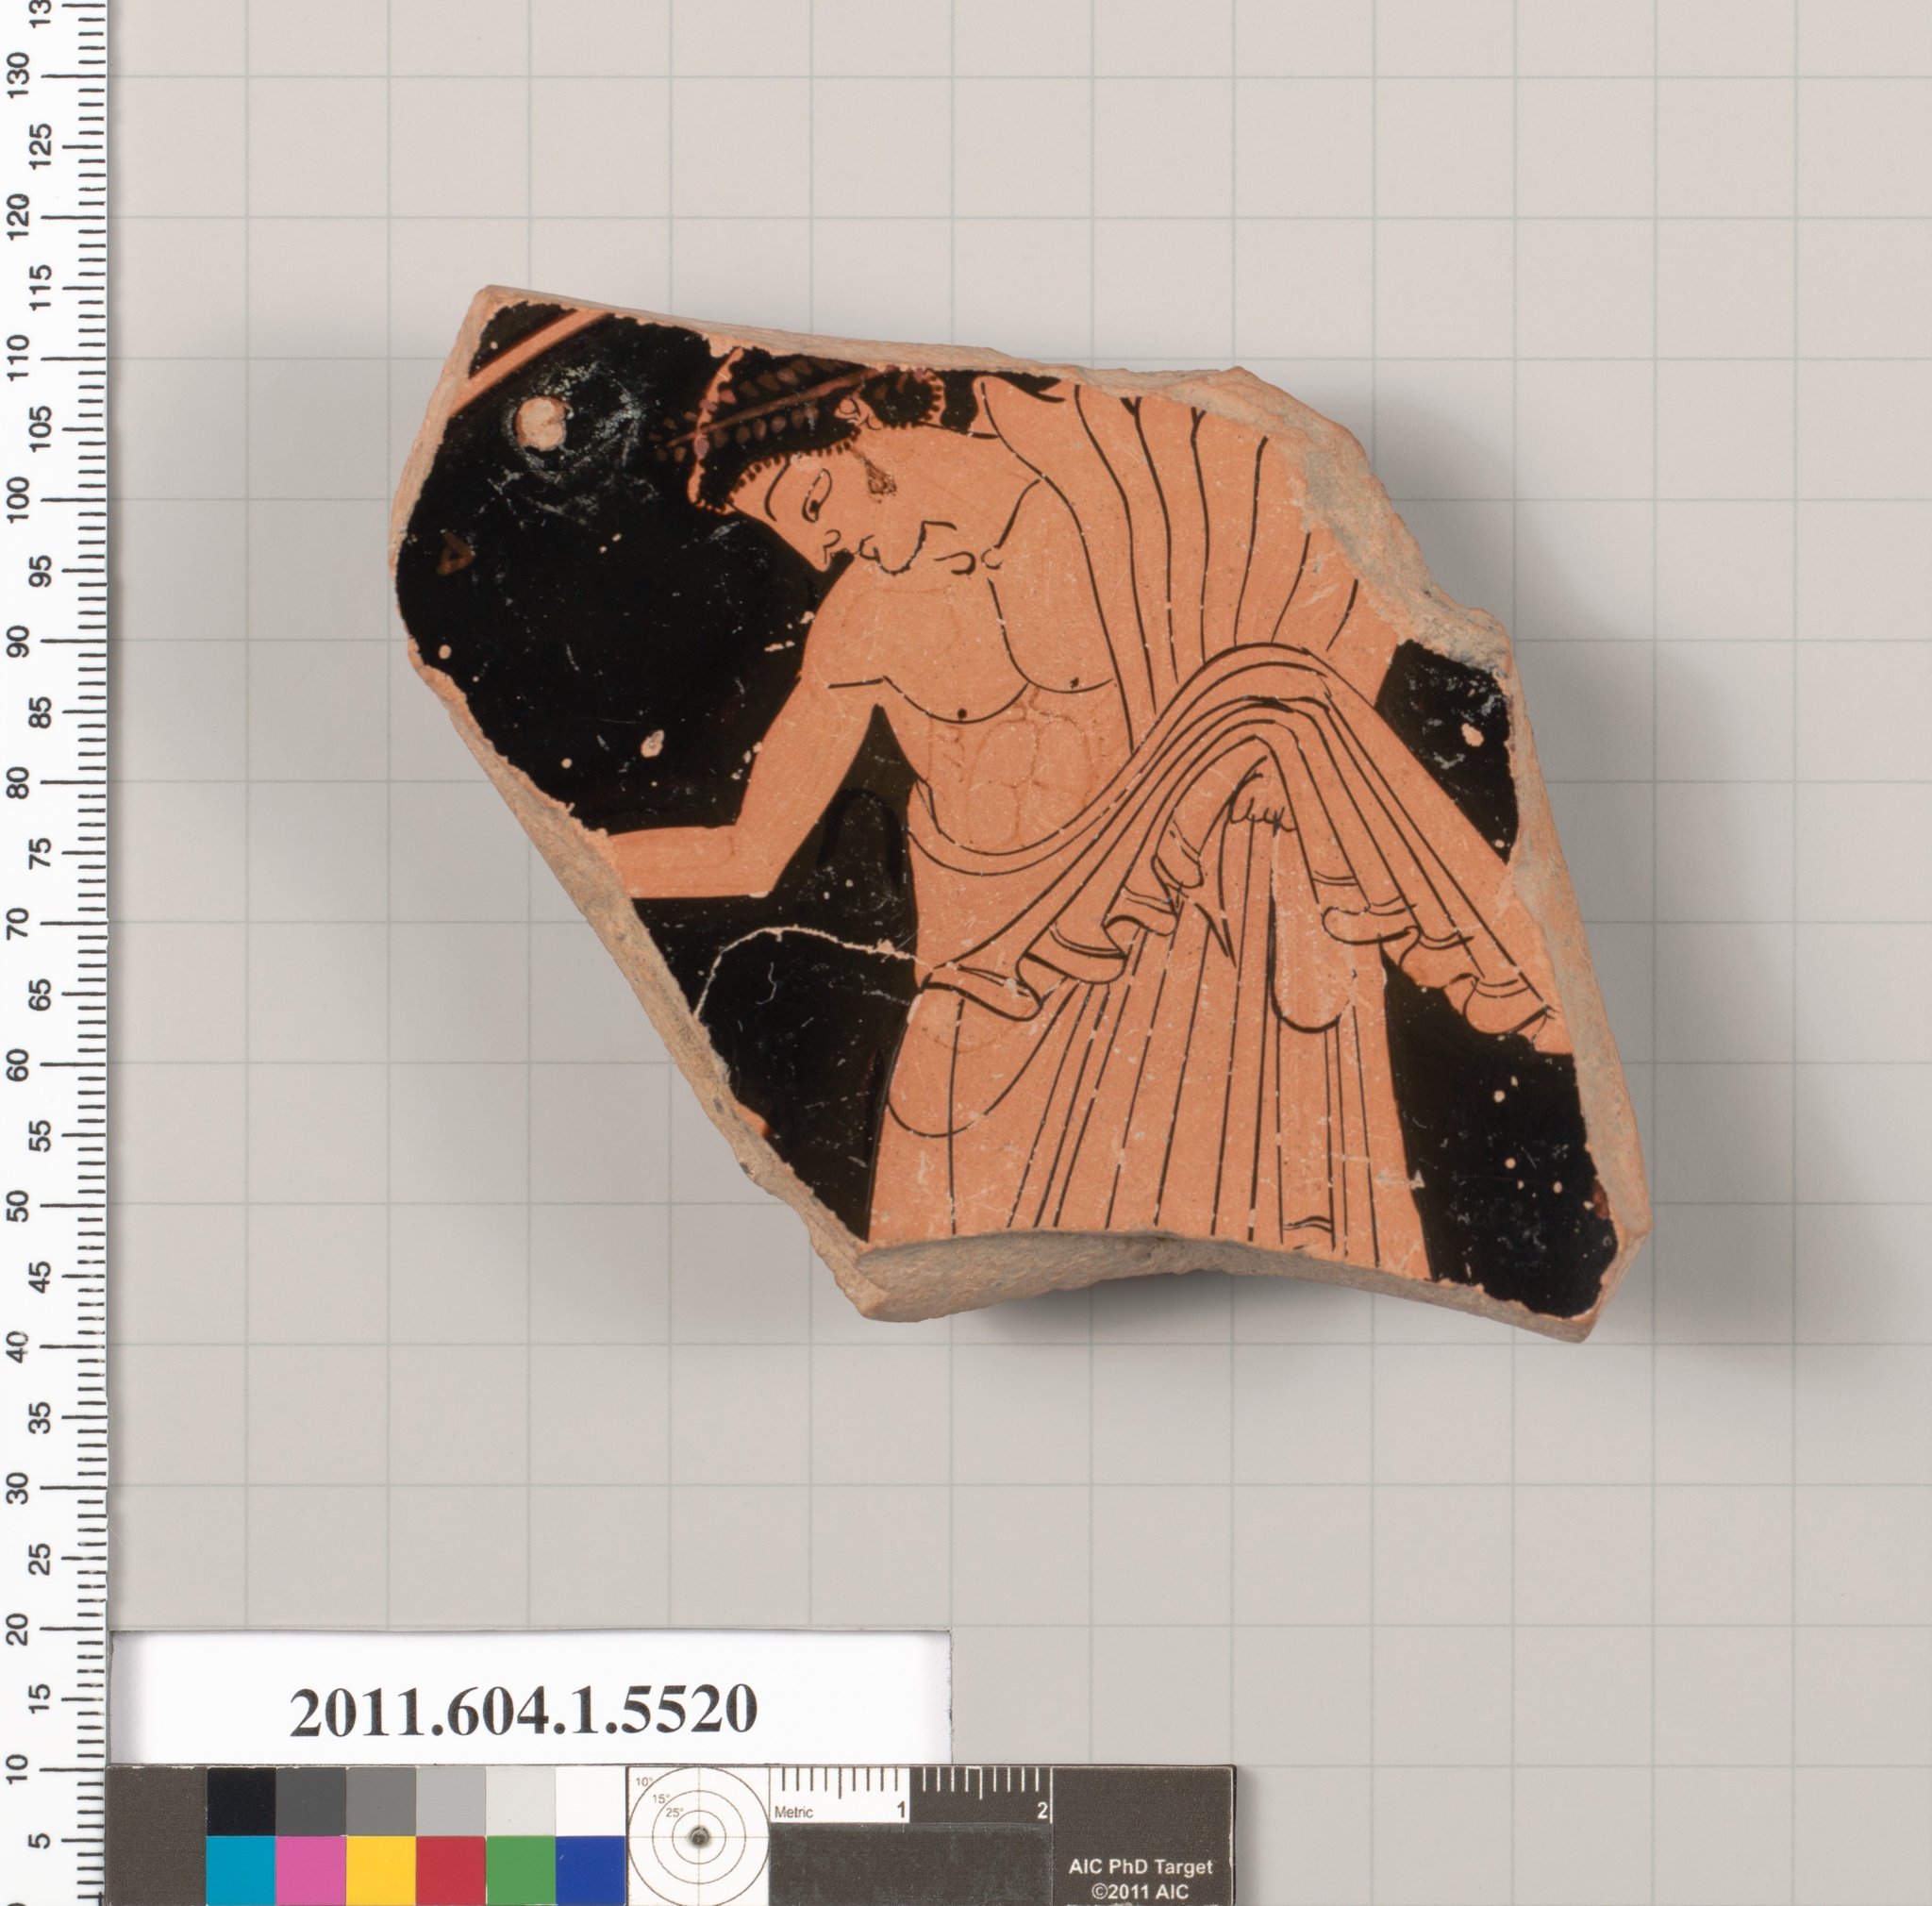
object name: kylix fragment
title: Terracotta fragment of a kylix (drinking cup)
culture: greek, attic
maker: ashby painter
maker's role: artist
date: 510-490 BCE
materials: terracotta